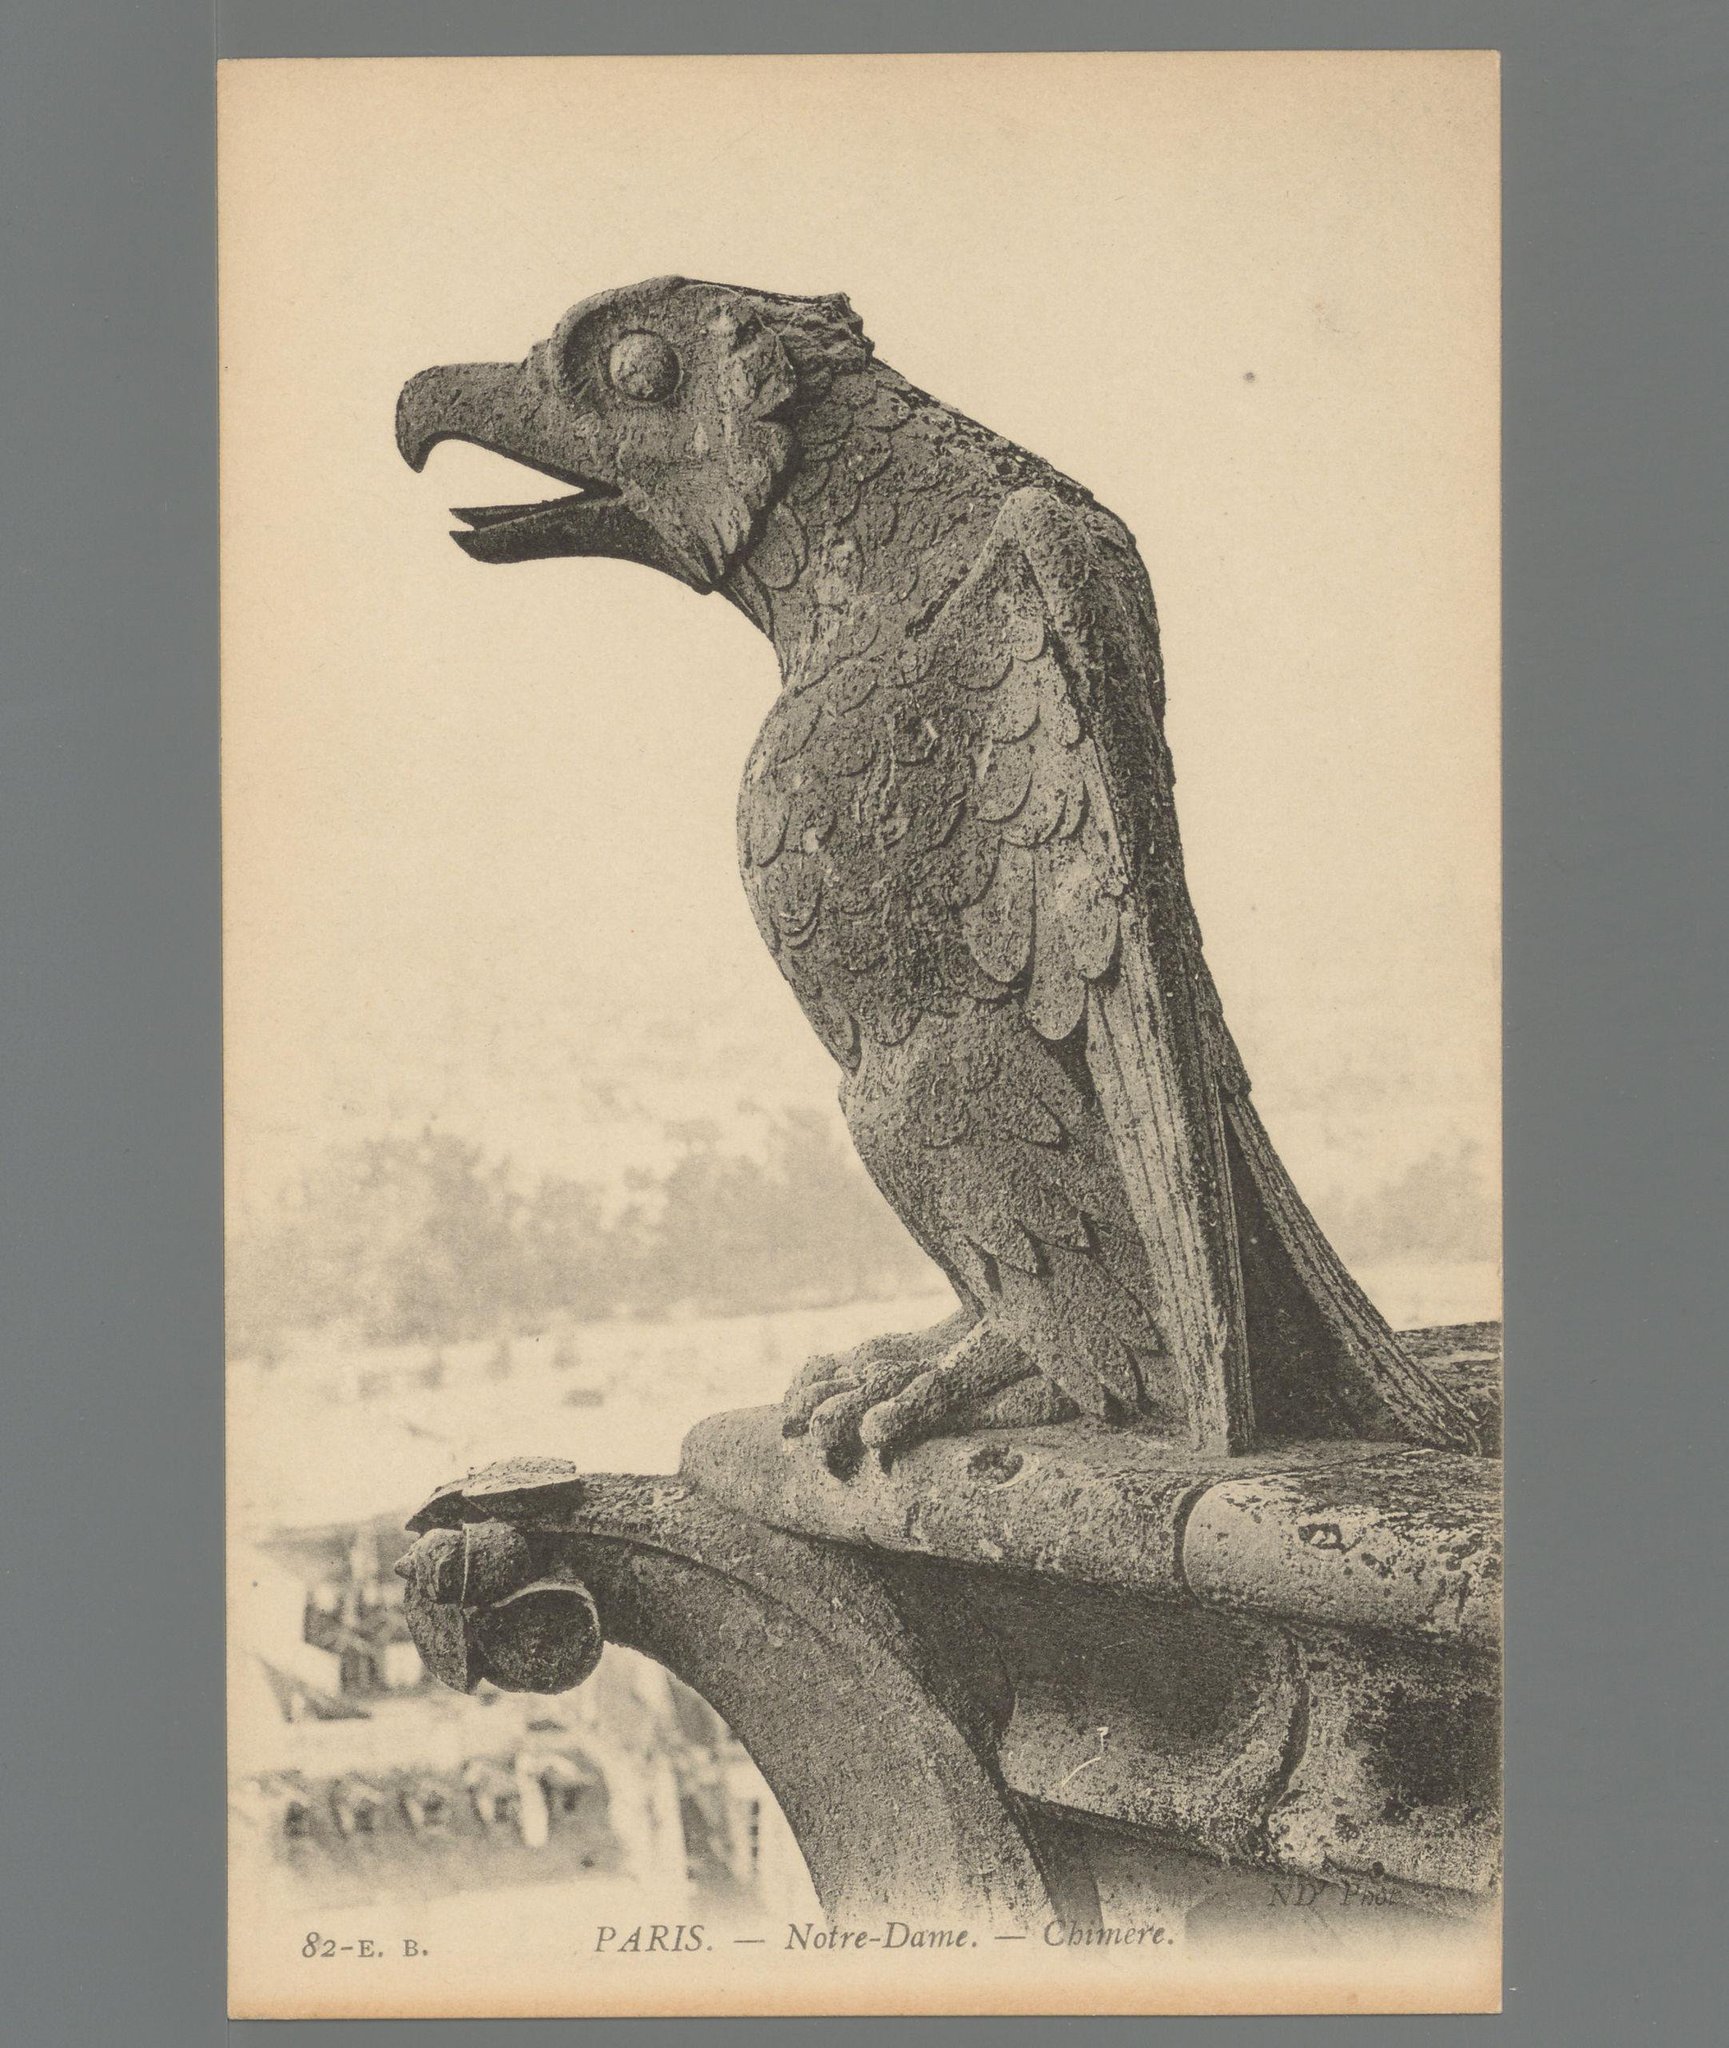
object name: ansichtkaart, prentbriefkaart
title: Paris. Notre-Dame. Chimère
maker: Anonymous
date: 1904-1906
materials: cardboard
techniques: photograph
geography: paris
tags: church (exterior), chimera (lion/goat/snake); 'chimera' (ripa), sculpture